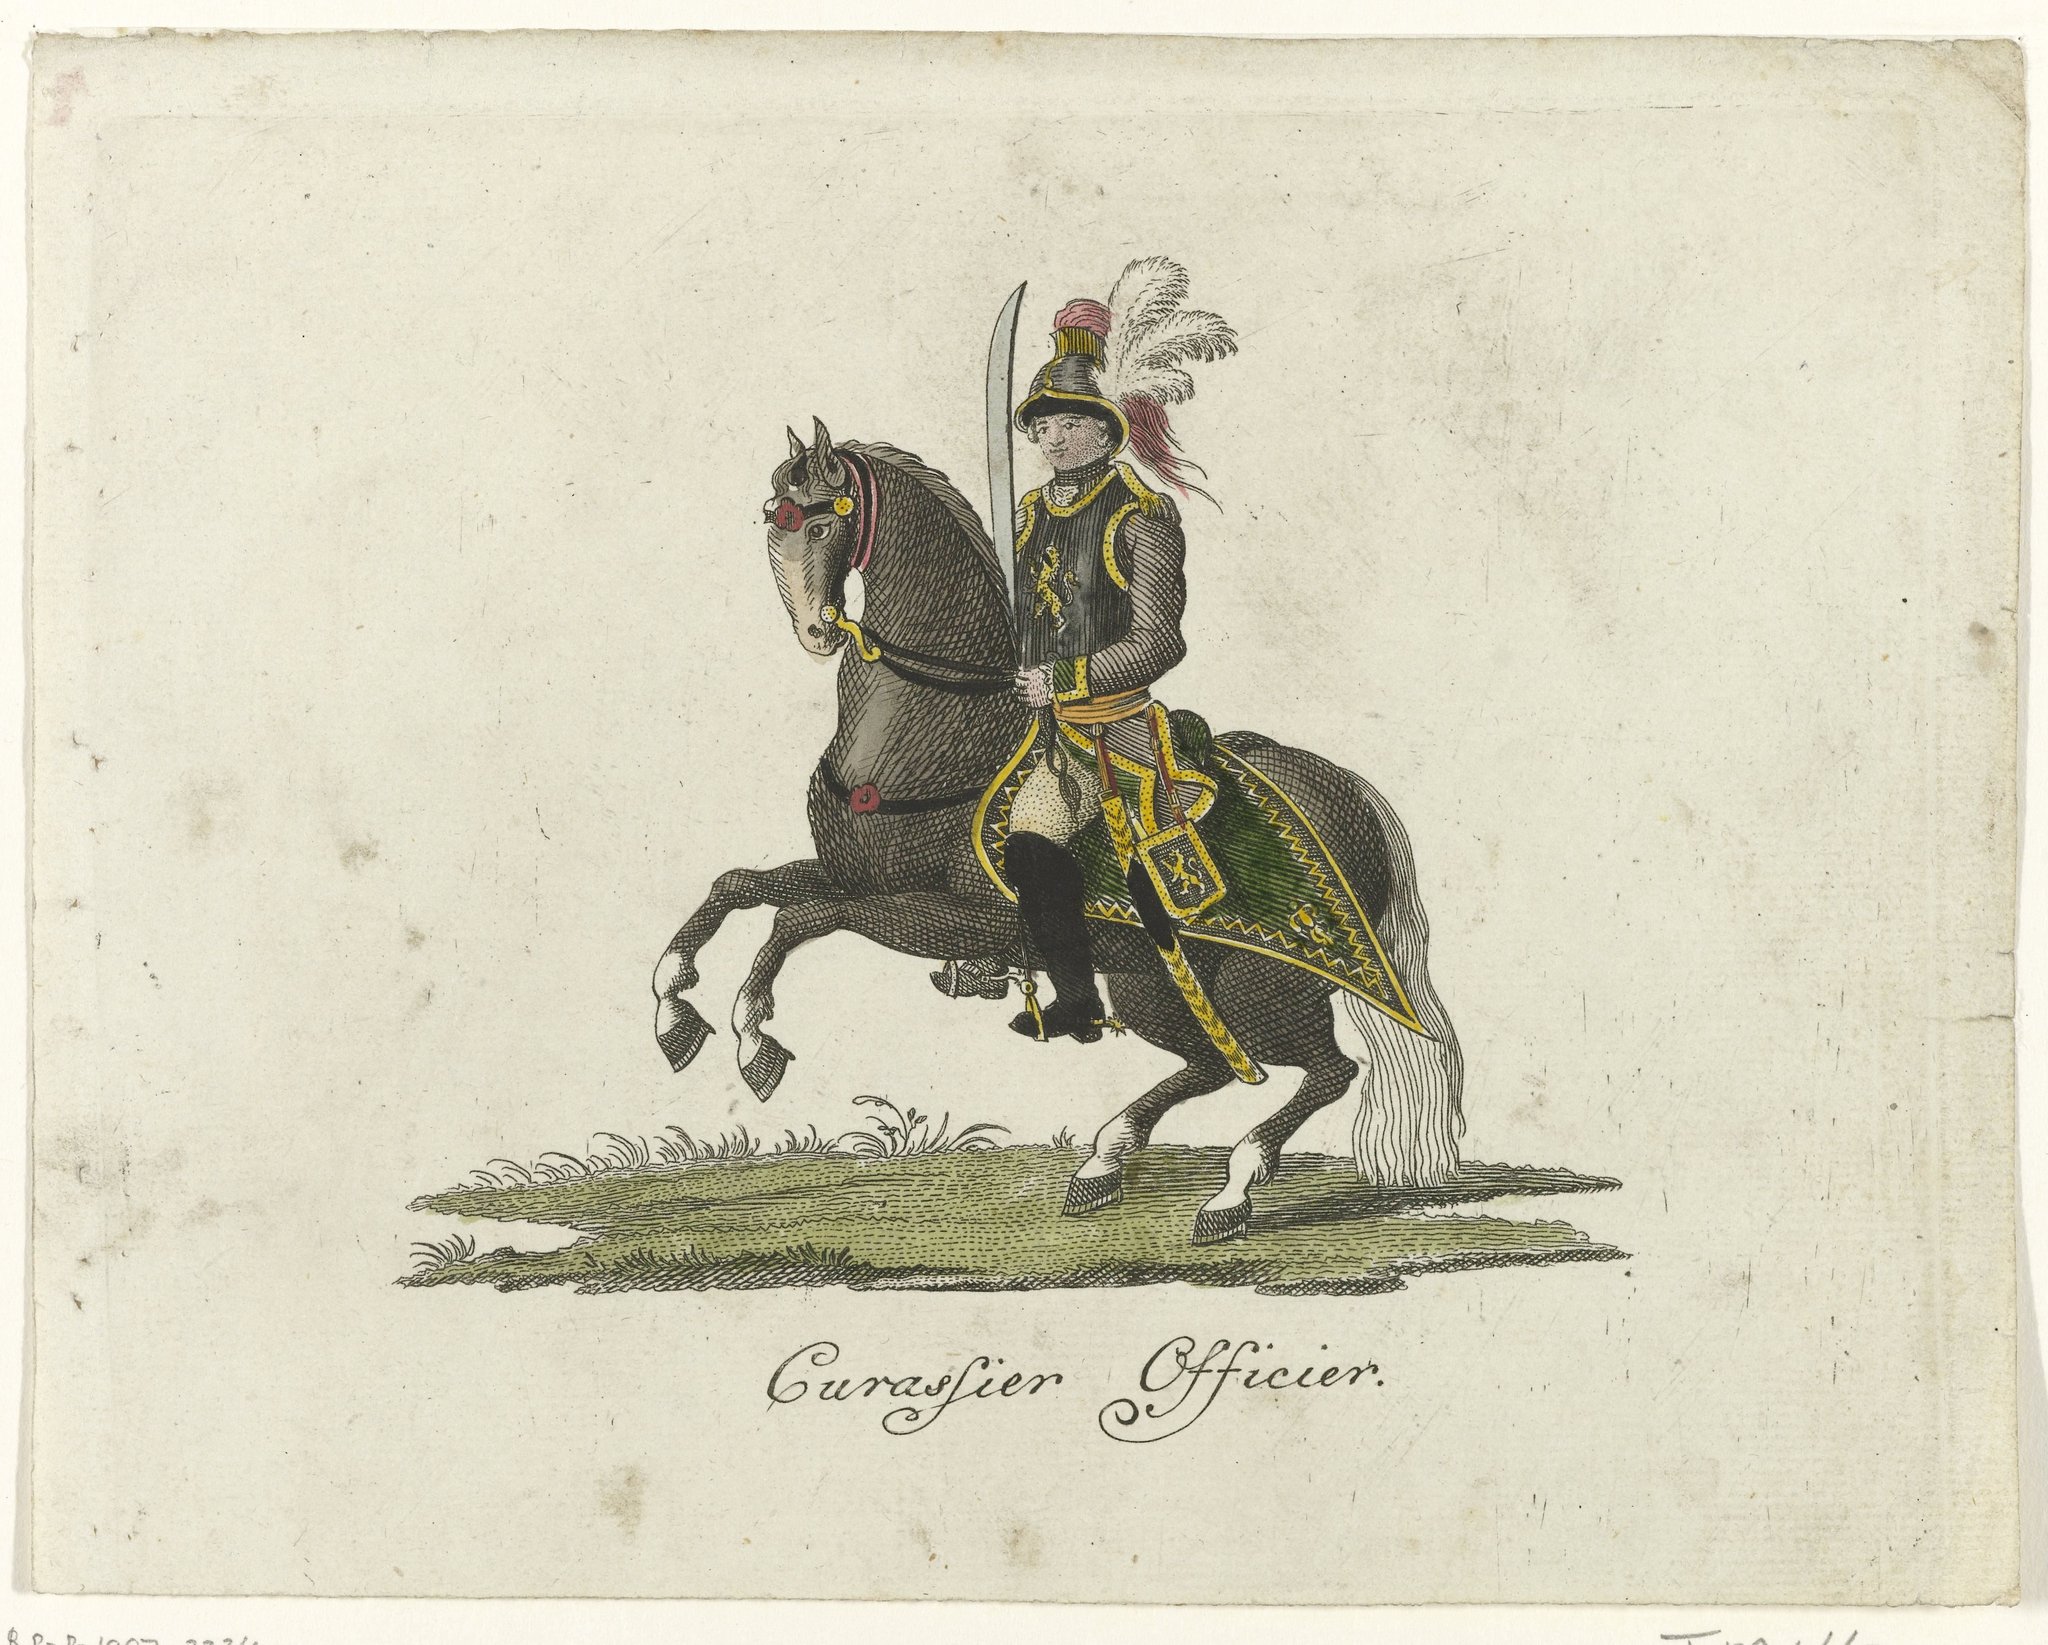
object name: print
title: Afbeeldinge Der Uniformen Van het Legioen lichte Troupen Van Den Hoog Gebore Heer Frederick Des H. Roomschen Rijcks Rhijn Grave van Salm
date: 1785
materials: paper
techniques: etching, hand coloring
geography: northern netherlands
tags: rijngraaf van salm frederik iii, (military) uniforms (+ cavalry, horsemen), patriots (1780-1795)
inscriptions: collector's mark: Lugt 2228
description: Kurassier in uniform te paard. Onderdeel van de prentserie van uniformen van het legioen van Frederik III Rijngraaf van Salm, in dienst van Republiek in 1785.